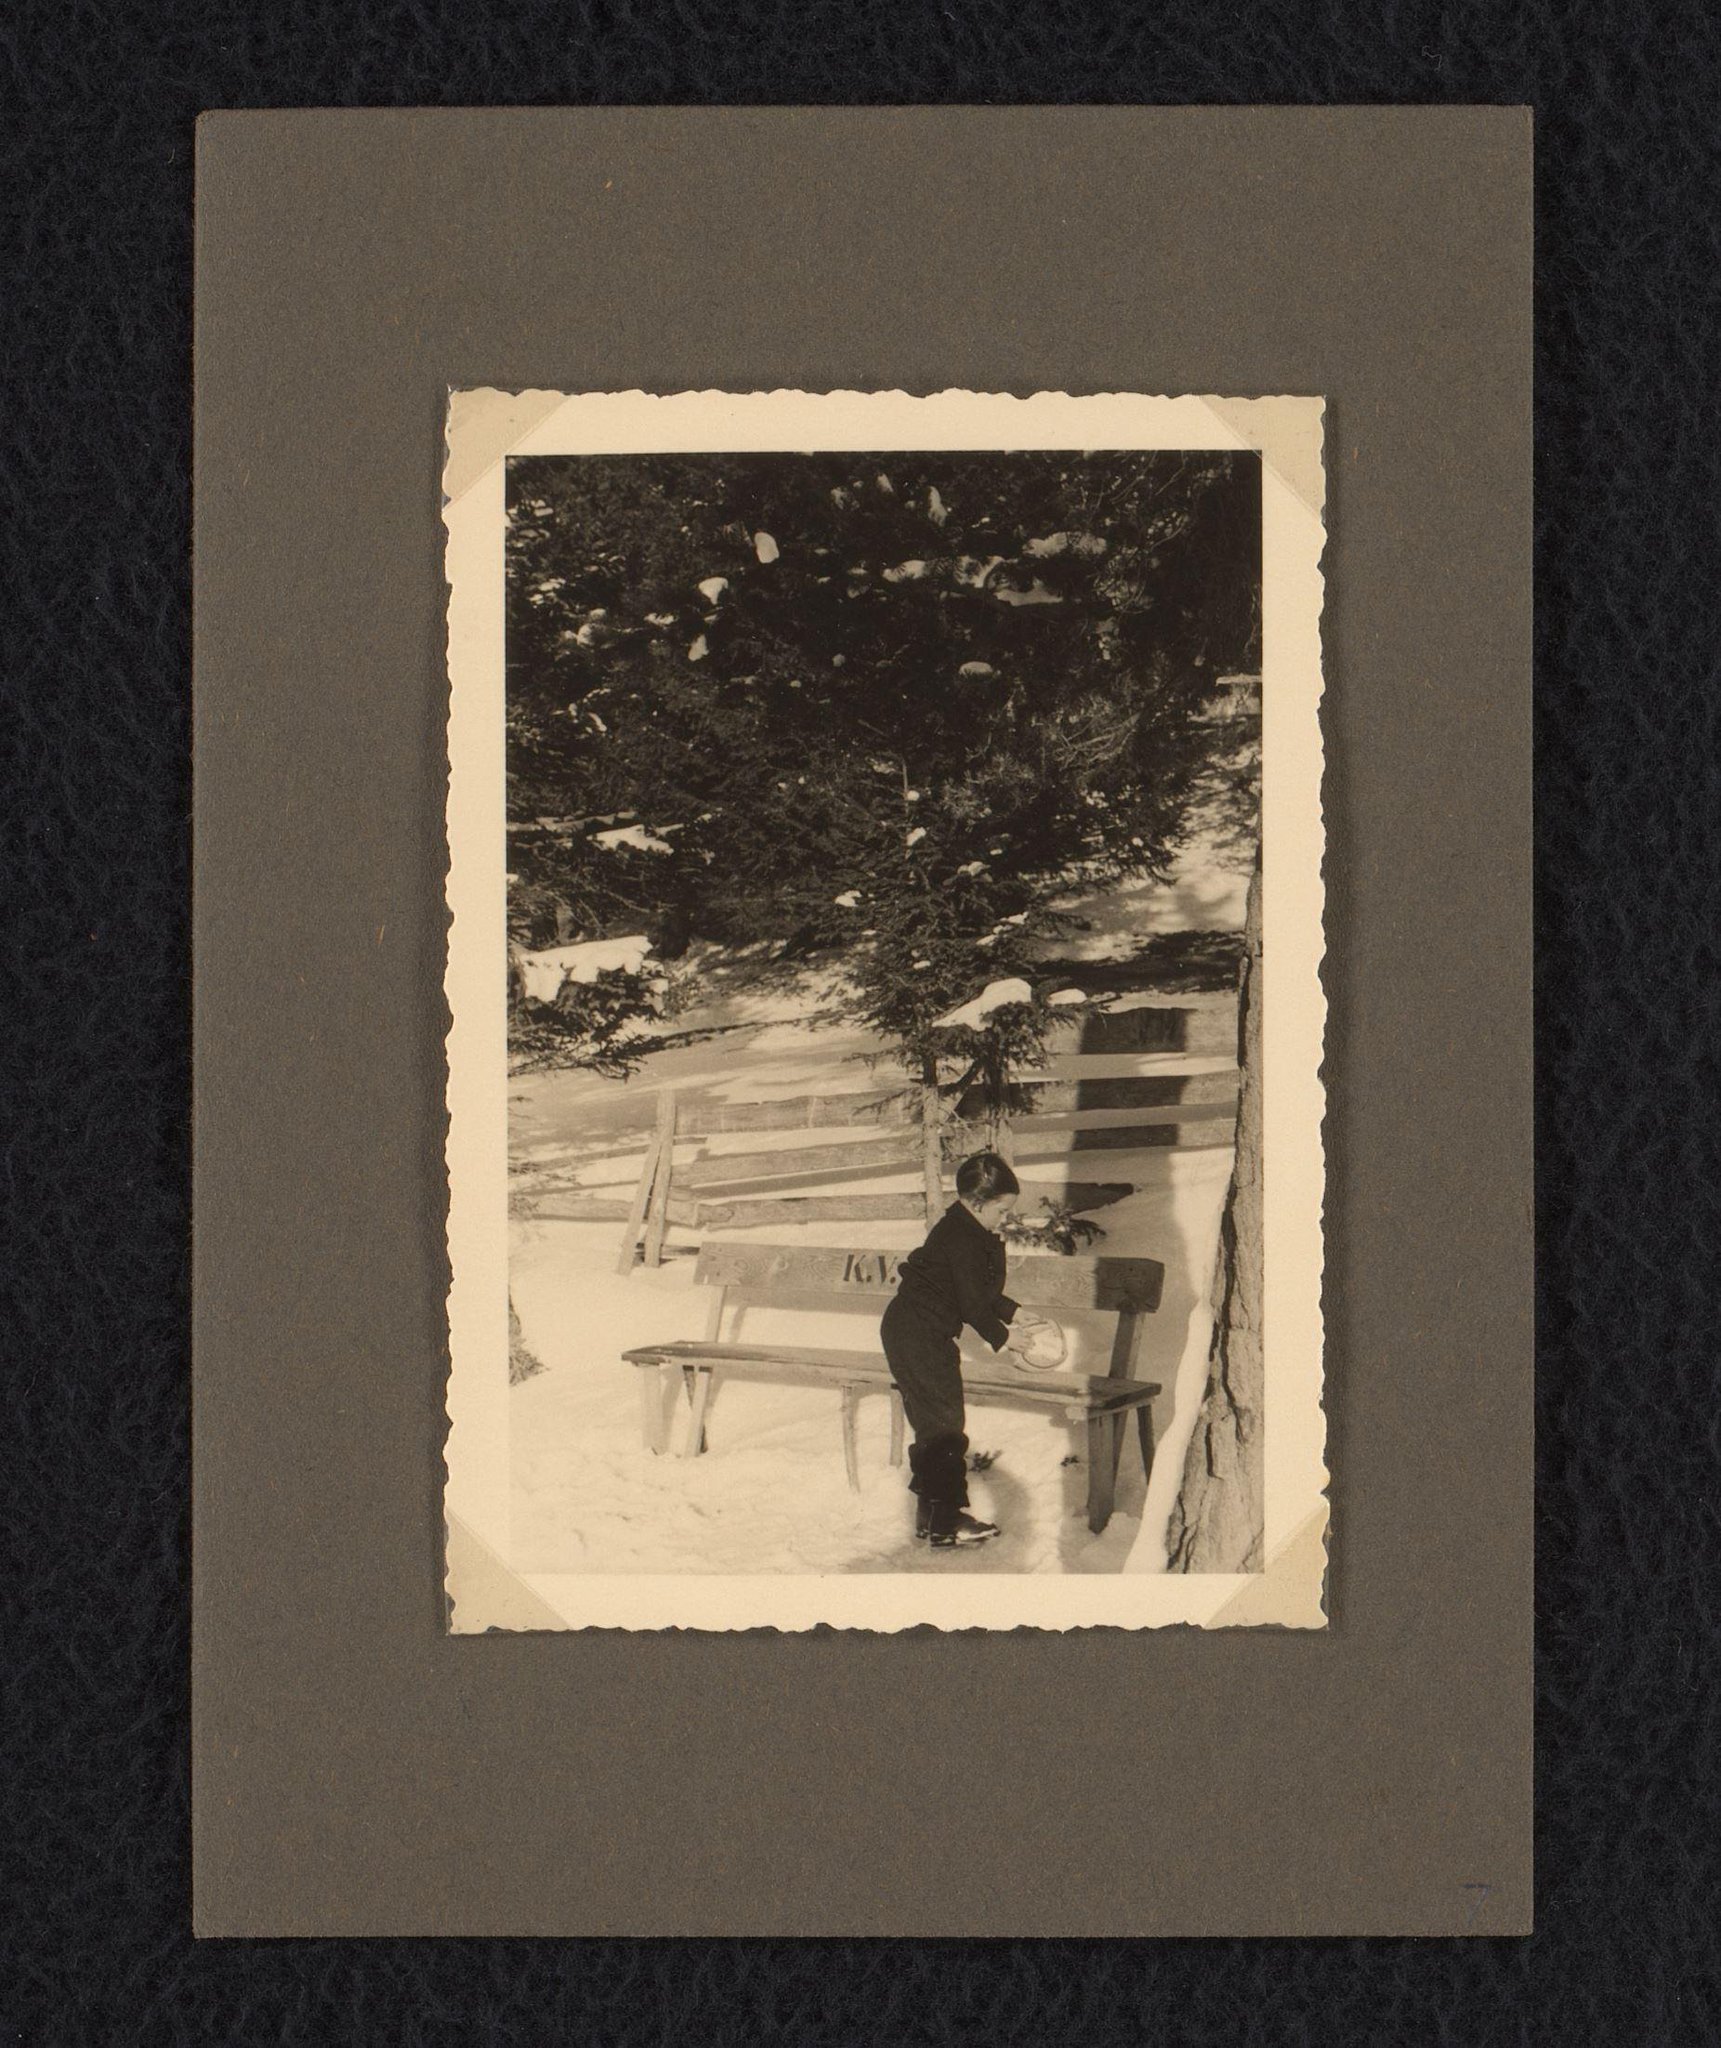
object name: photograph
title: Isabel bij een bankje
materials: cardboard, photographic support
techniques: gelatin silver print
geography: lenzerheide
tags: leiden, isabel wachenheimer-elon, the family travelling, on holiday, snow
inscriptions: date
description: Albumblad met een foto van Isabel Wachenheimer in de sneeuw bij een zitbank. Onderdeel van het fotoalbum met vakantiefoto's Lenzerheide, 1934.